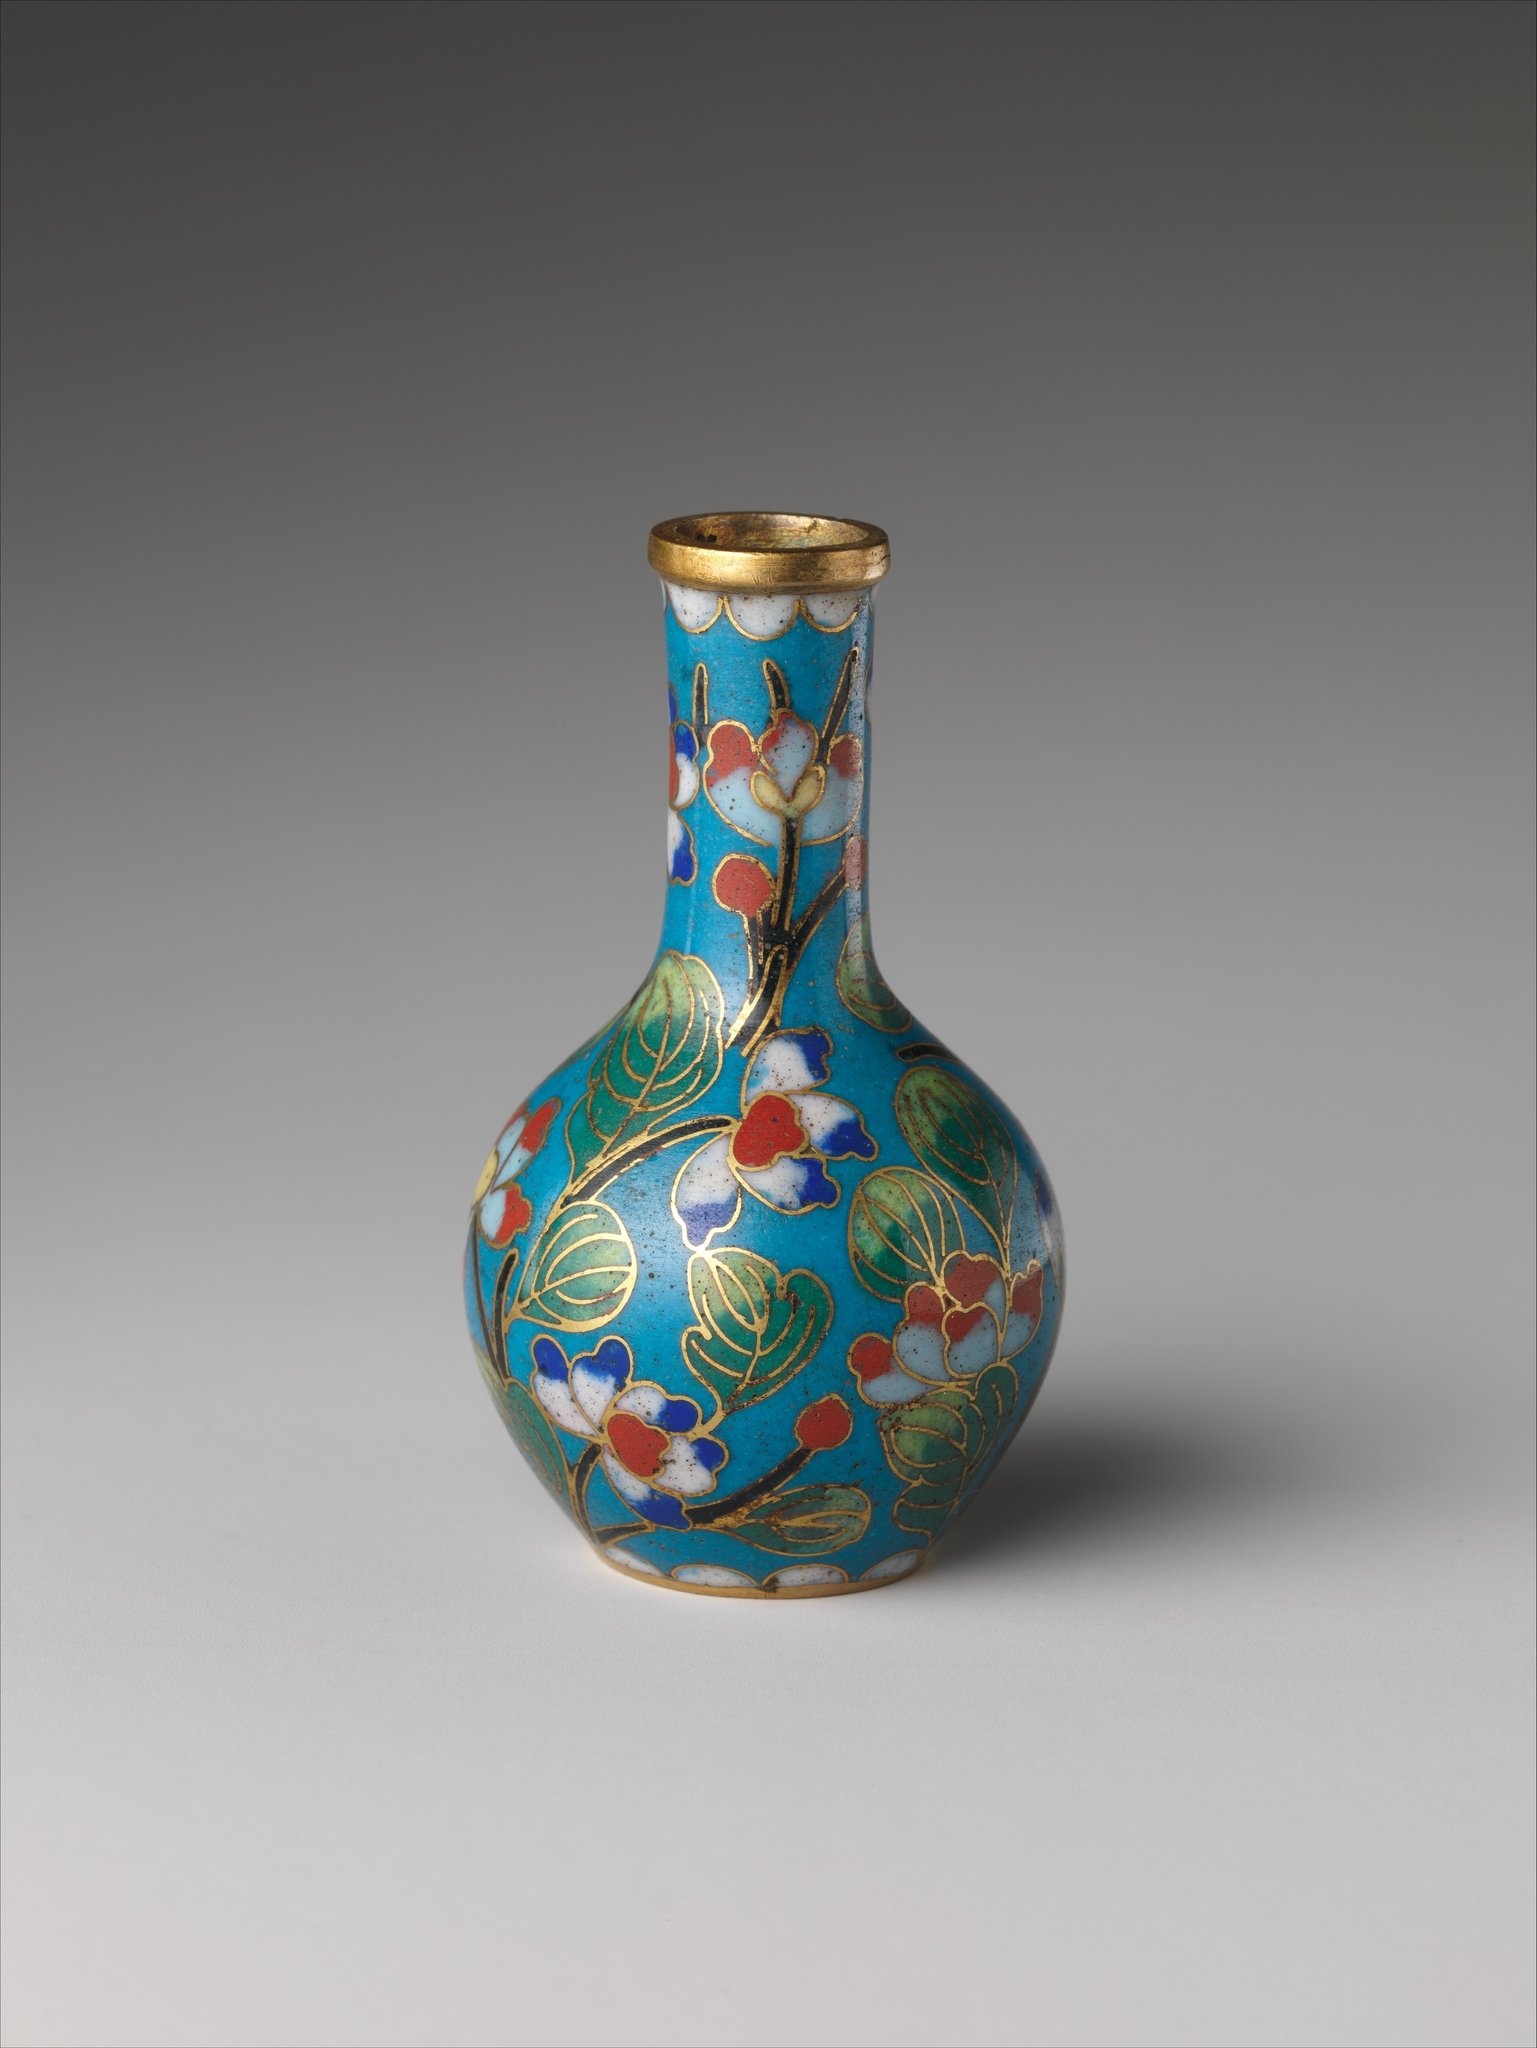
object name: vase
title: Vase from sample set of Chinese cloisonné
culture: chinese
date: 1867-1900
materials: copper alloy, enamel, glass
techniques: enamel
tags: flowers,leaves